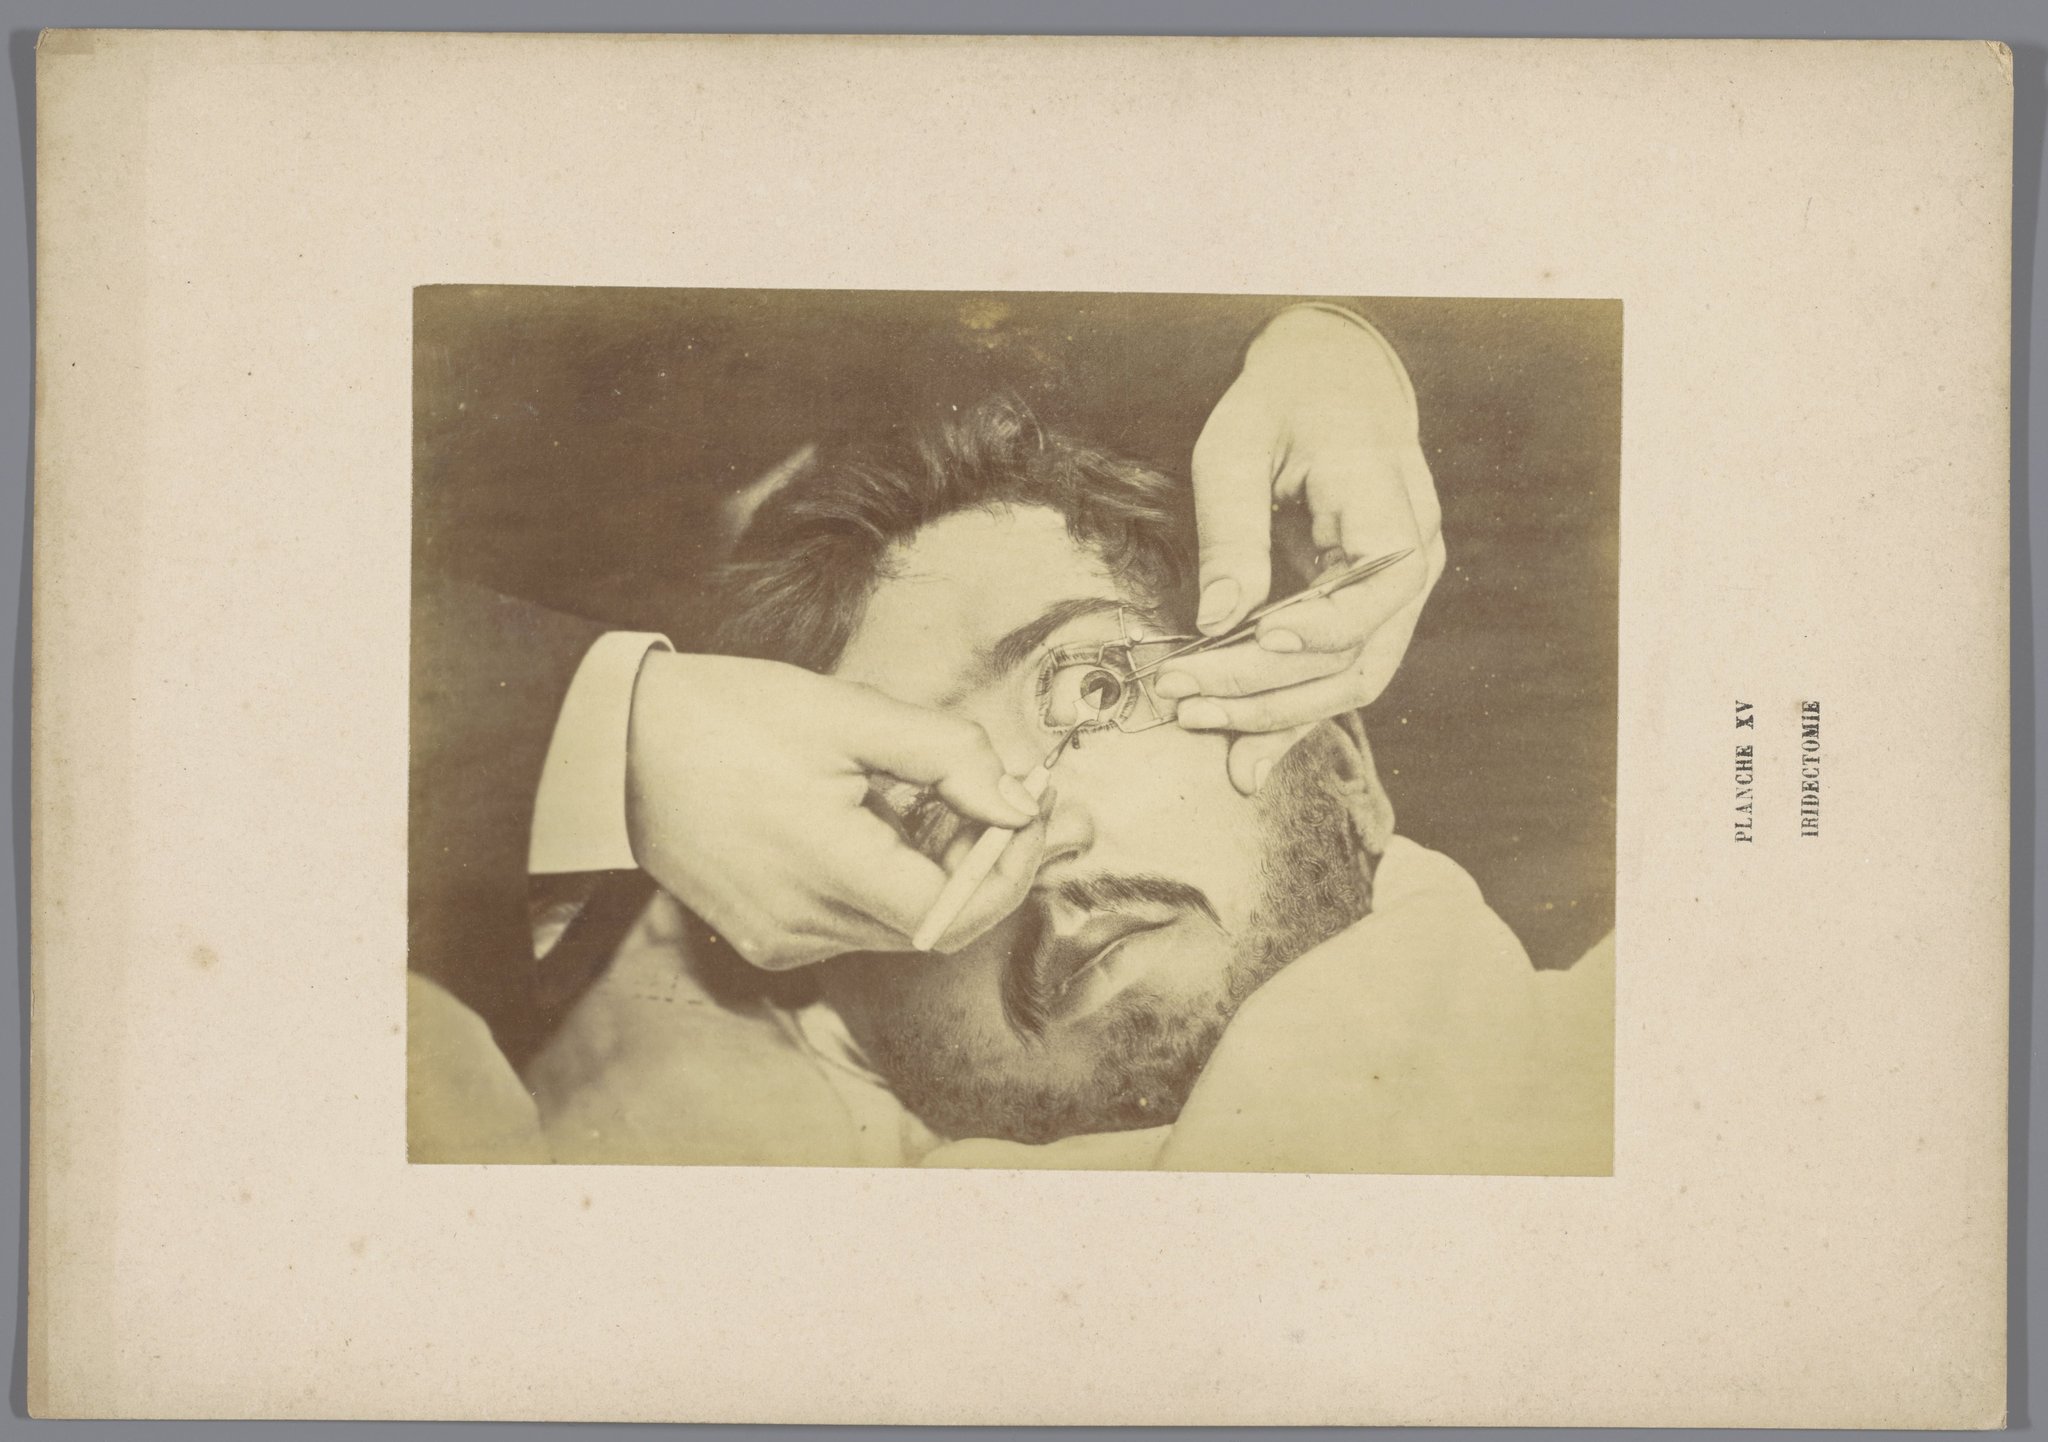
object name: photograph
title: Iridectomie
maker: a. de montméja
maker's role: arts, fotograaf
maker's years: 1841-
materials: photographic support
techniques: albumen print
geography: france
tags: eyes, operation, surgery, disabilities affecting the eyes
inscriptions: number: ‘Planche XV’